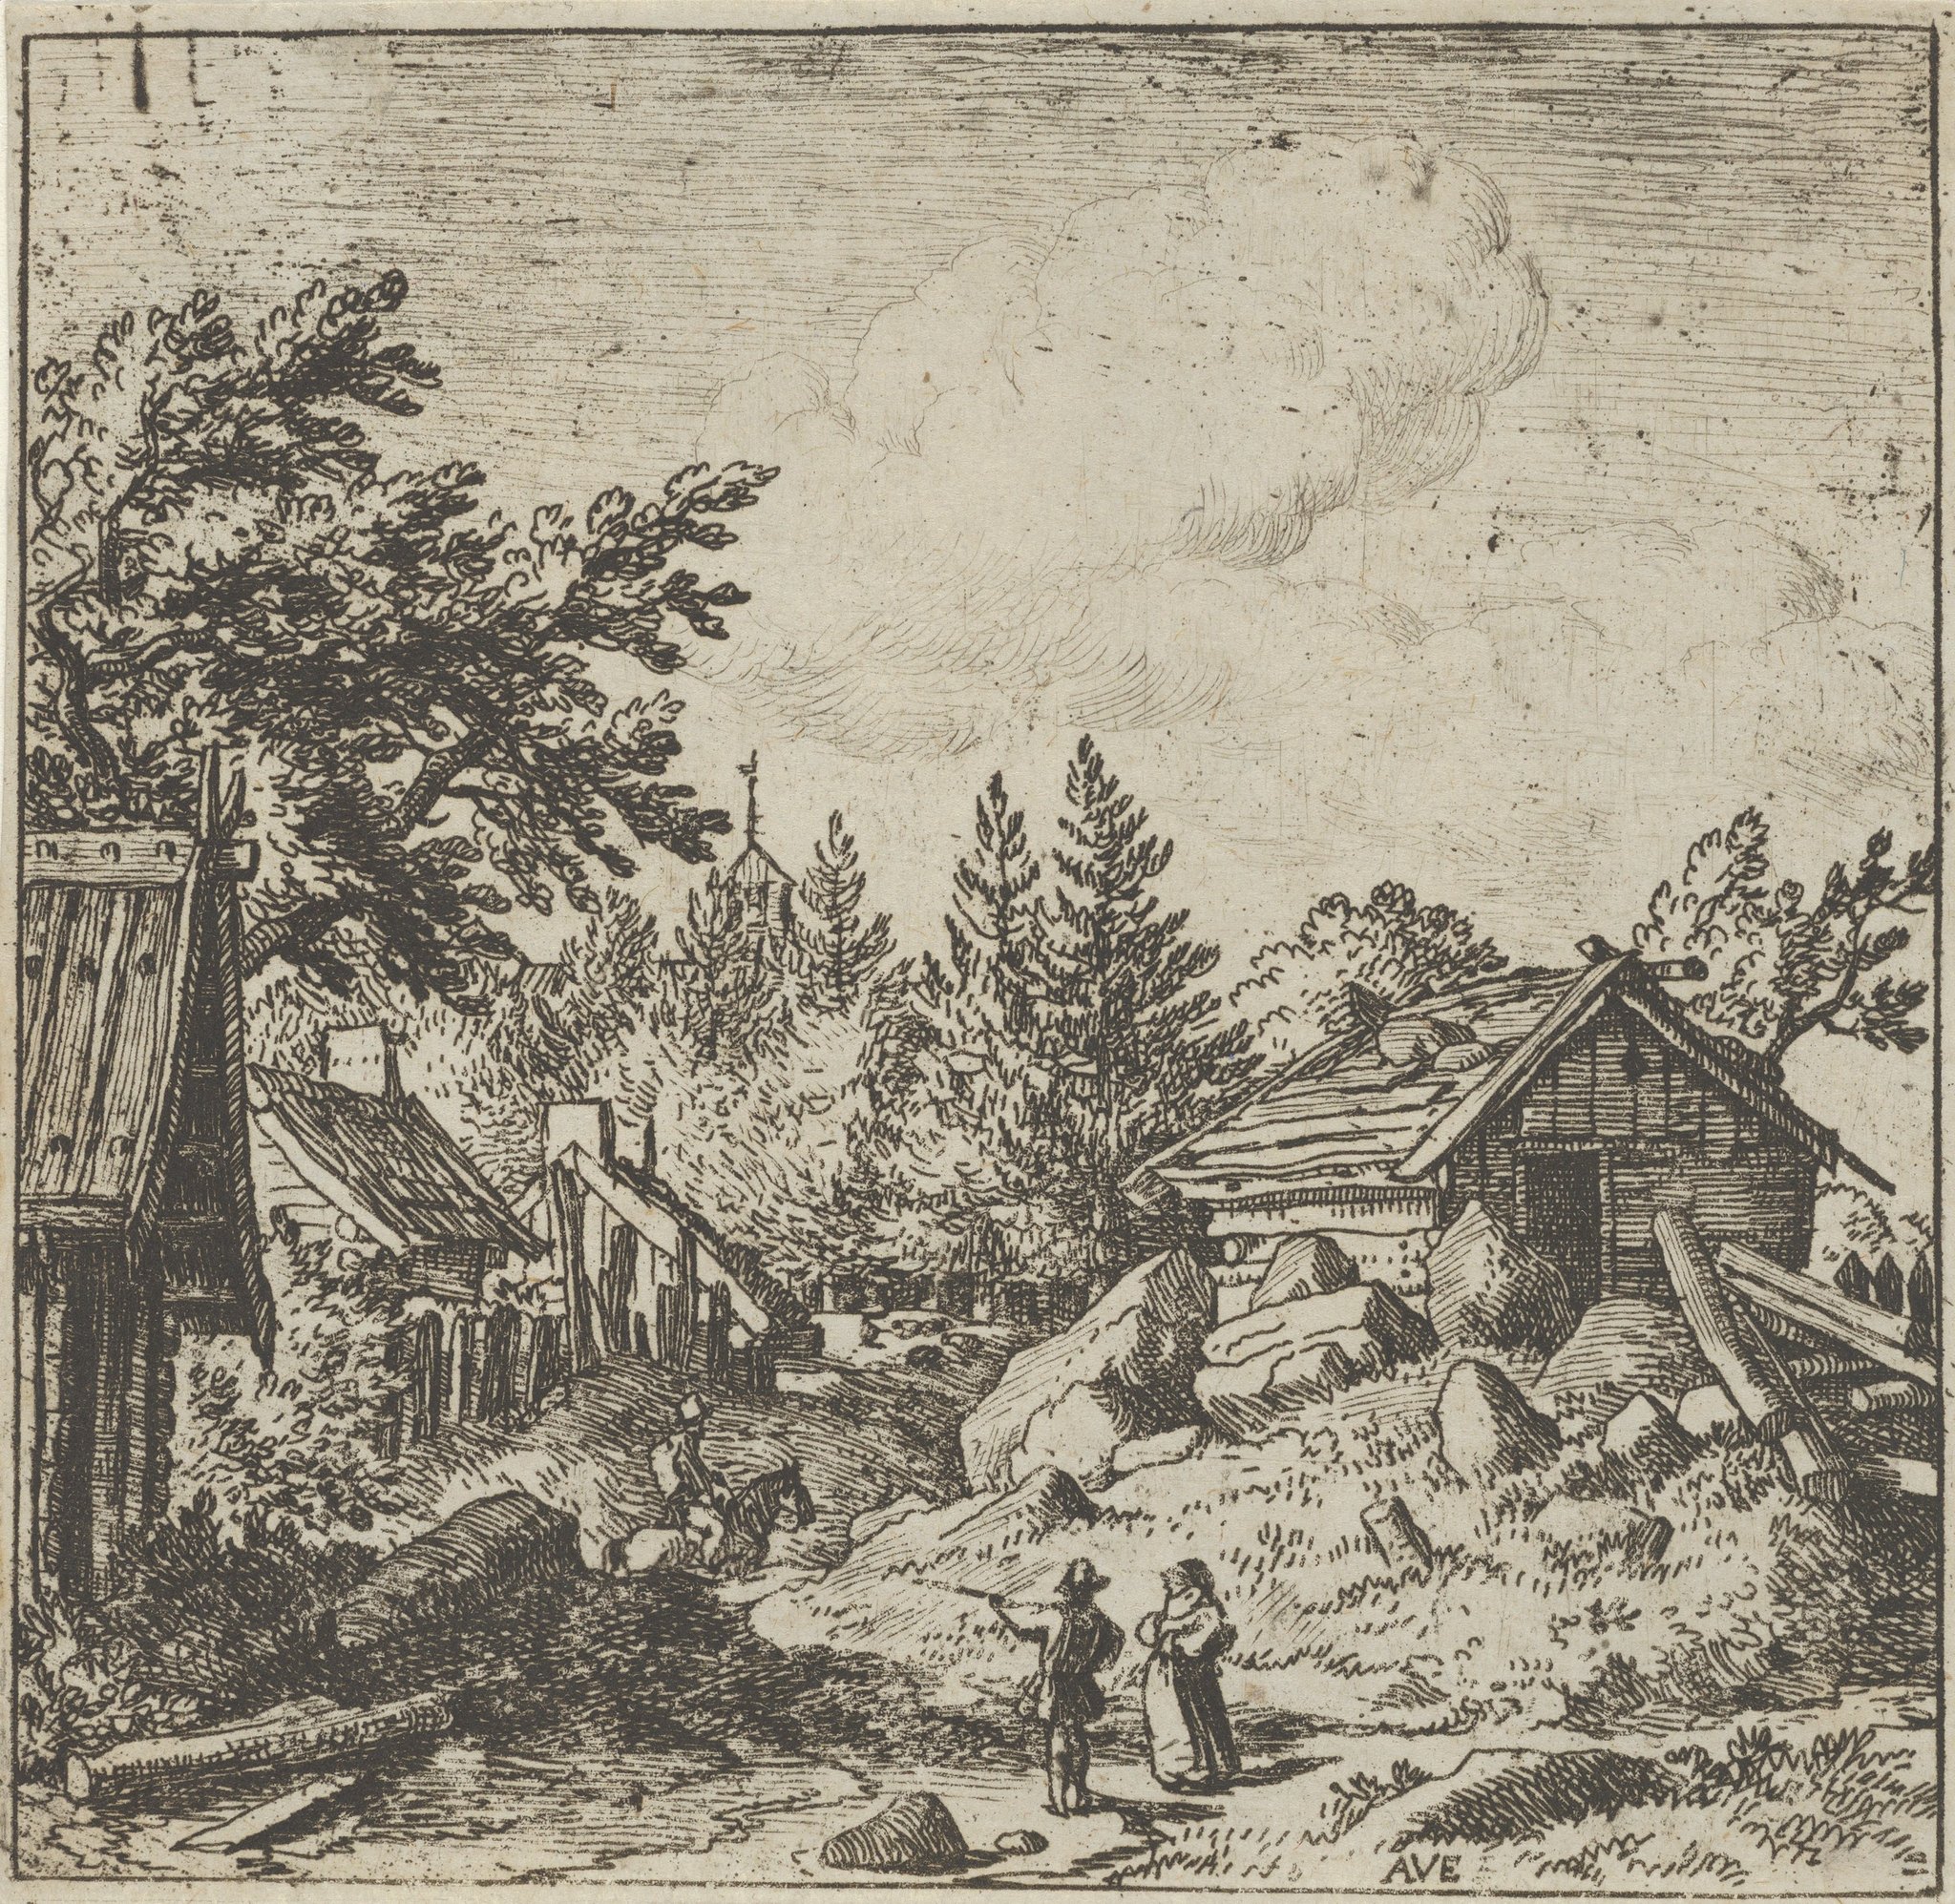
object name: print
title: The Hamlet on the Montainous Ground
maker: allart van everdingen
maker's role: artist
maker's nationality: dutch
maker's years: 1621-1675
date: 1621-1675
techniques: engraving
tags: houses,men,women,trees